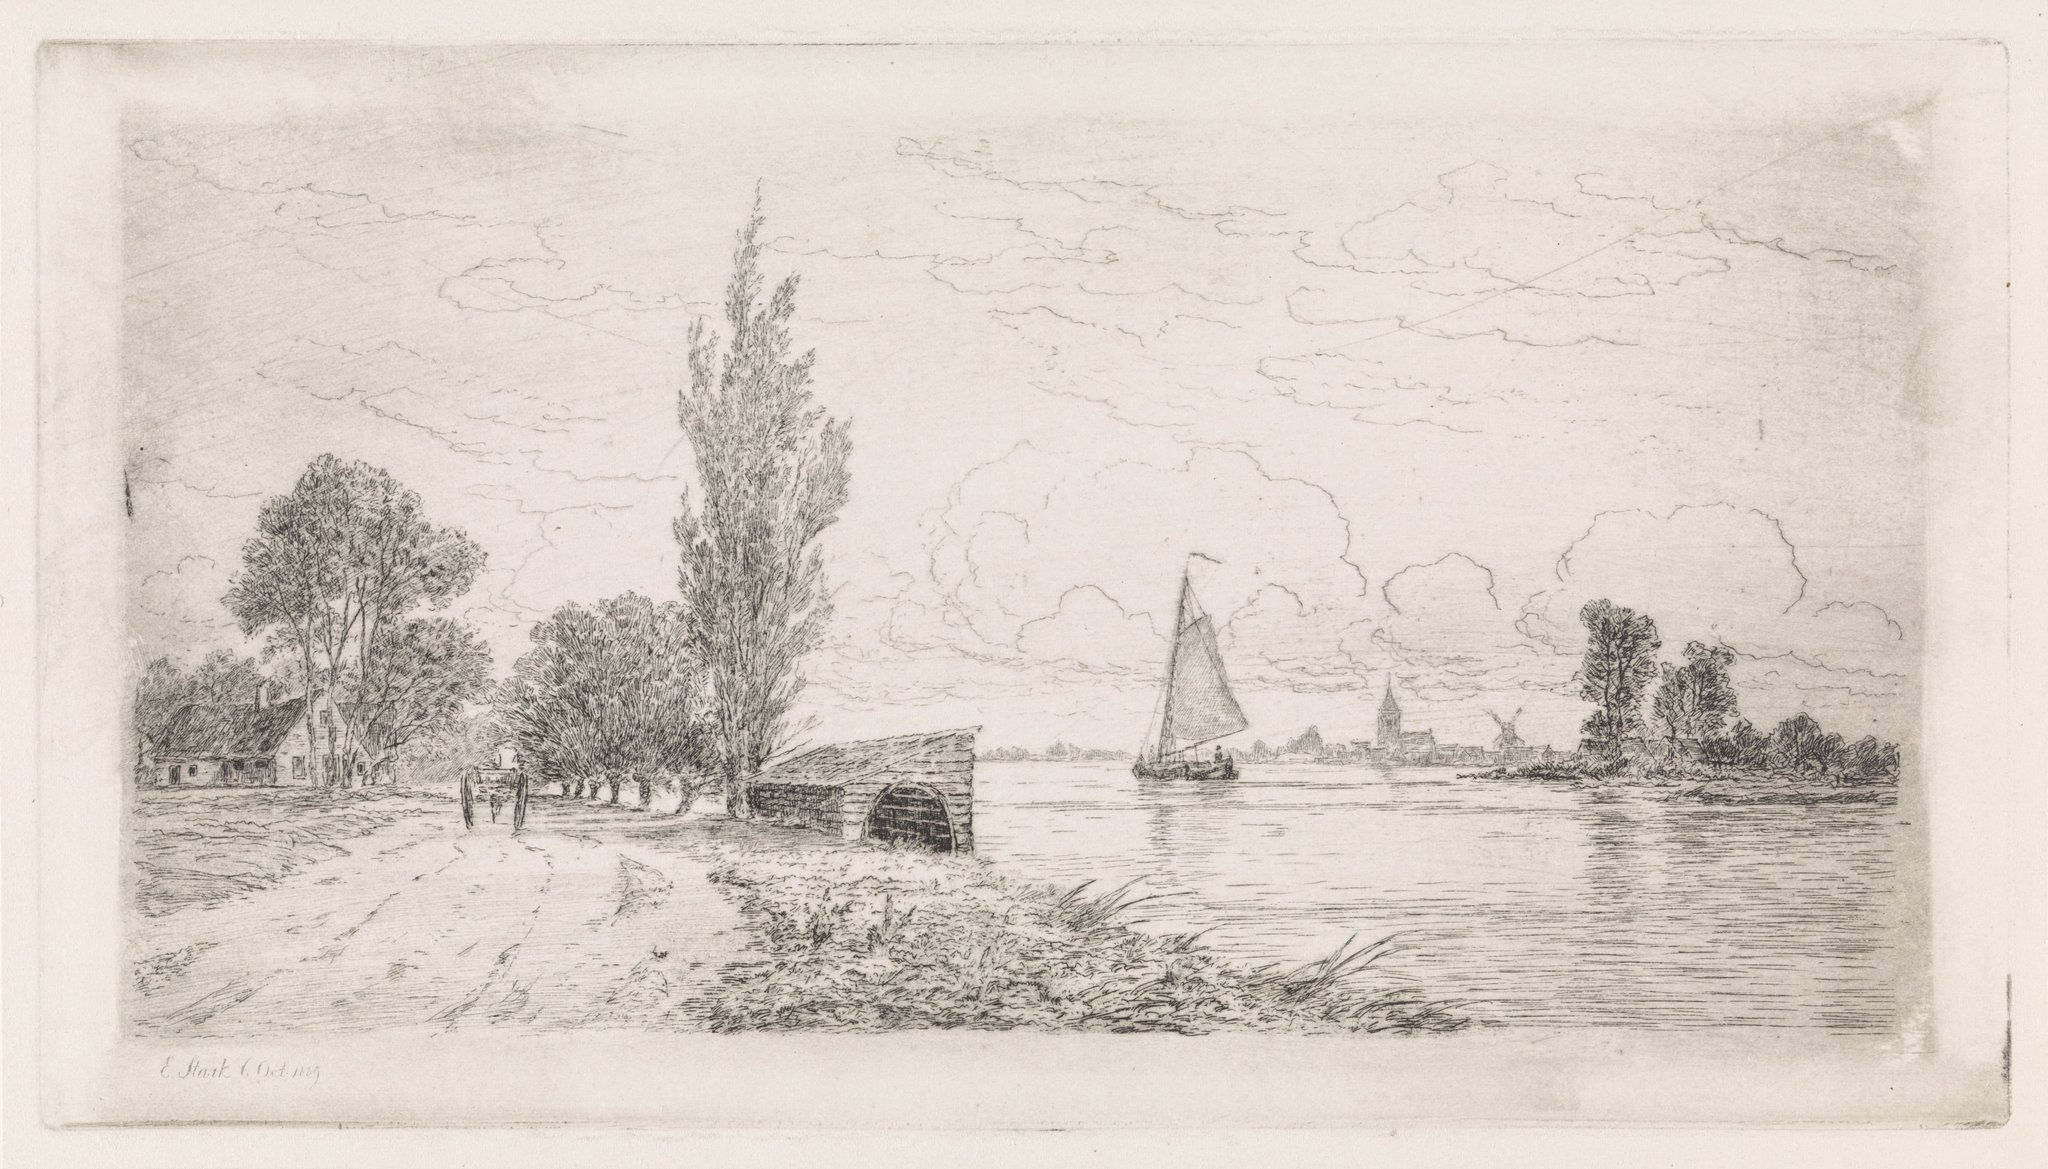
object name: print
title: Rivierlandschap met zeilschip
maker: elias stark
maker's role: draughtsman, print maker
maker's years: 1849-1933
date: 1889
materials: paper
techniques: aquatint, etching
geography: nieuwer-amstel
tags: sailing-ship, sailing-boat, river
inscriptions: collector's mark: Lugt 2228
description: Landschap met op de rivier een zeilschip en op de achtergrond een dorp. Links langs het water een weg waarop een wagen rijdt.